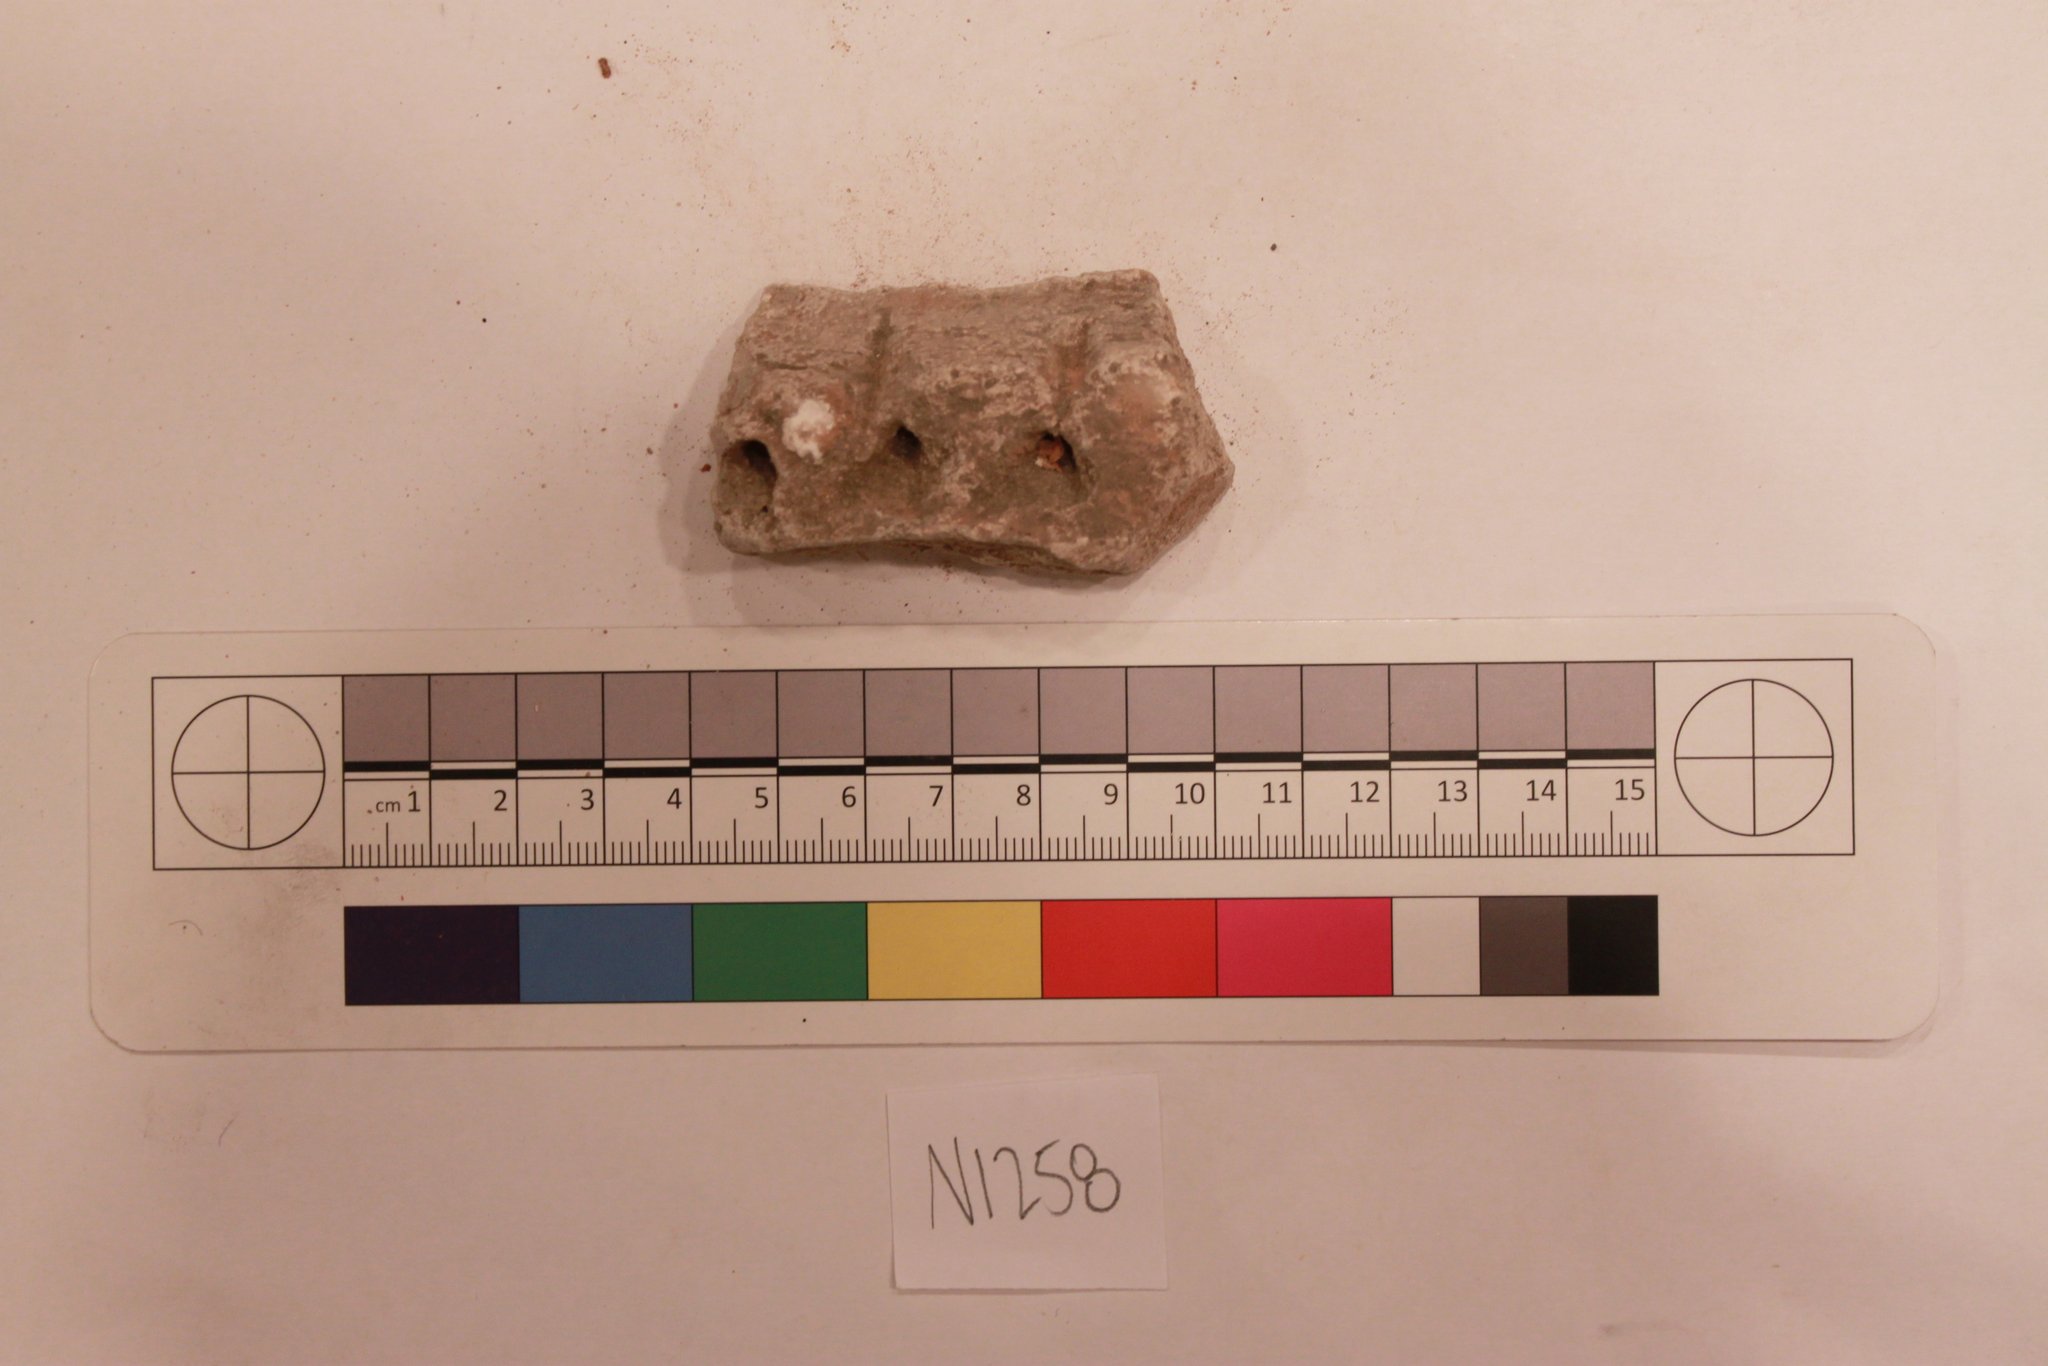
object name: fragment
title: Stucco Fragment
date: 701-1200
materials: plaster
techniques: carving, painting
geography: iran